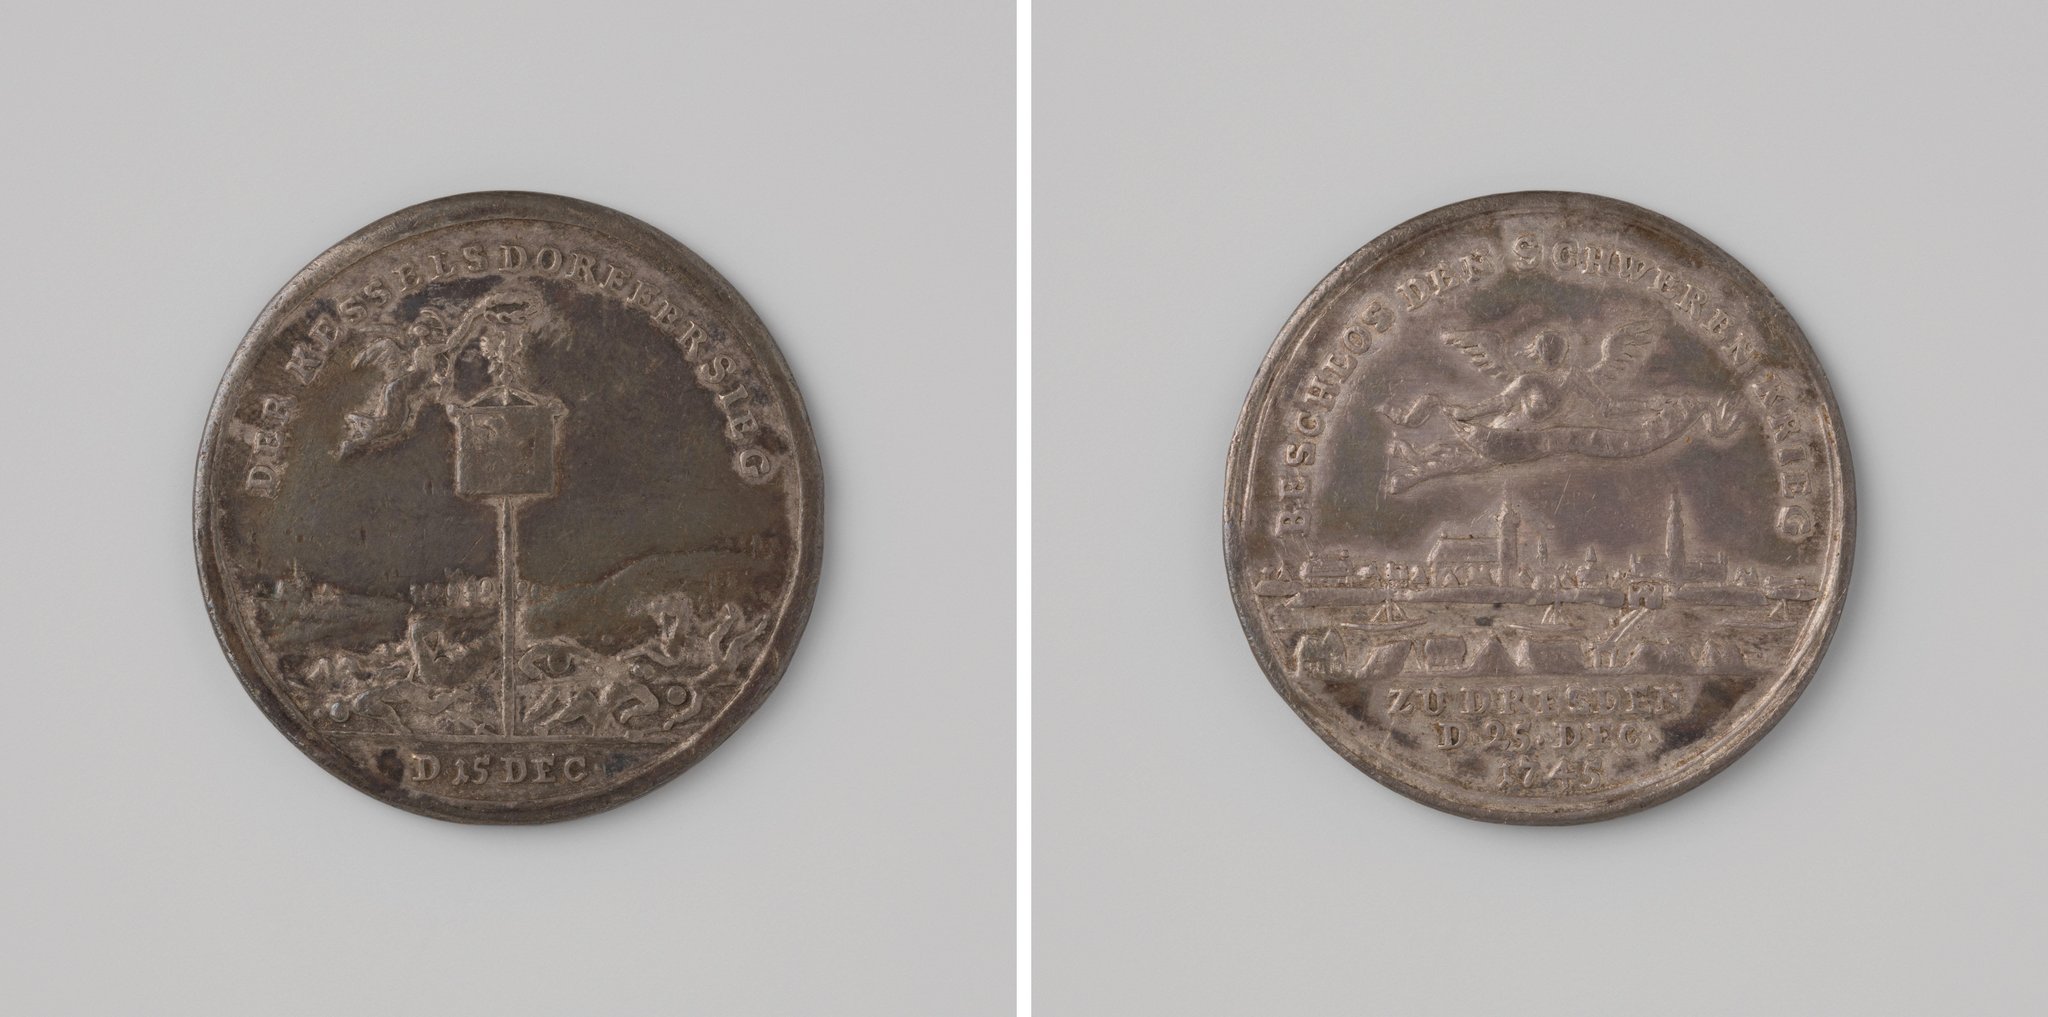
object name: history medal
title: Overwinning bij Kesseldorf en vrede van Dresden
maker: Anonymous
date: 1745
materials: silver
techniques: striking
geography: germany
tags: saksen, kesselsdorf, dresden, oostenrijkse successieoorlog, vrede van dresden (1745), slag bij kesselsdorf